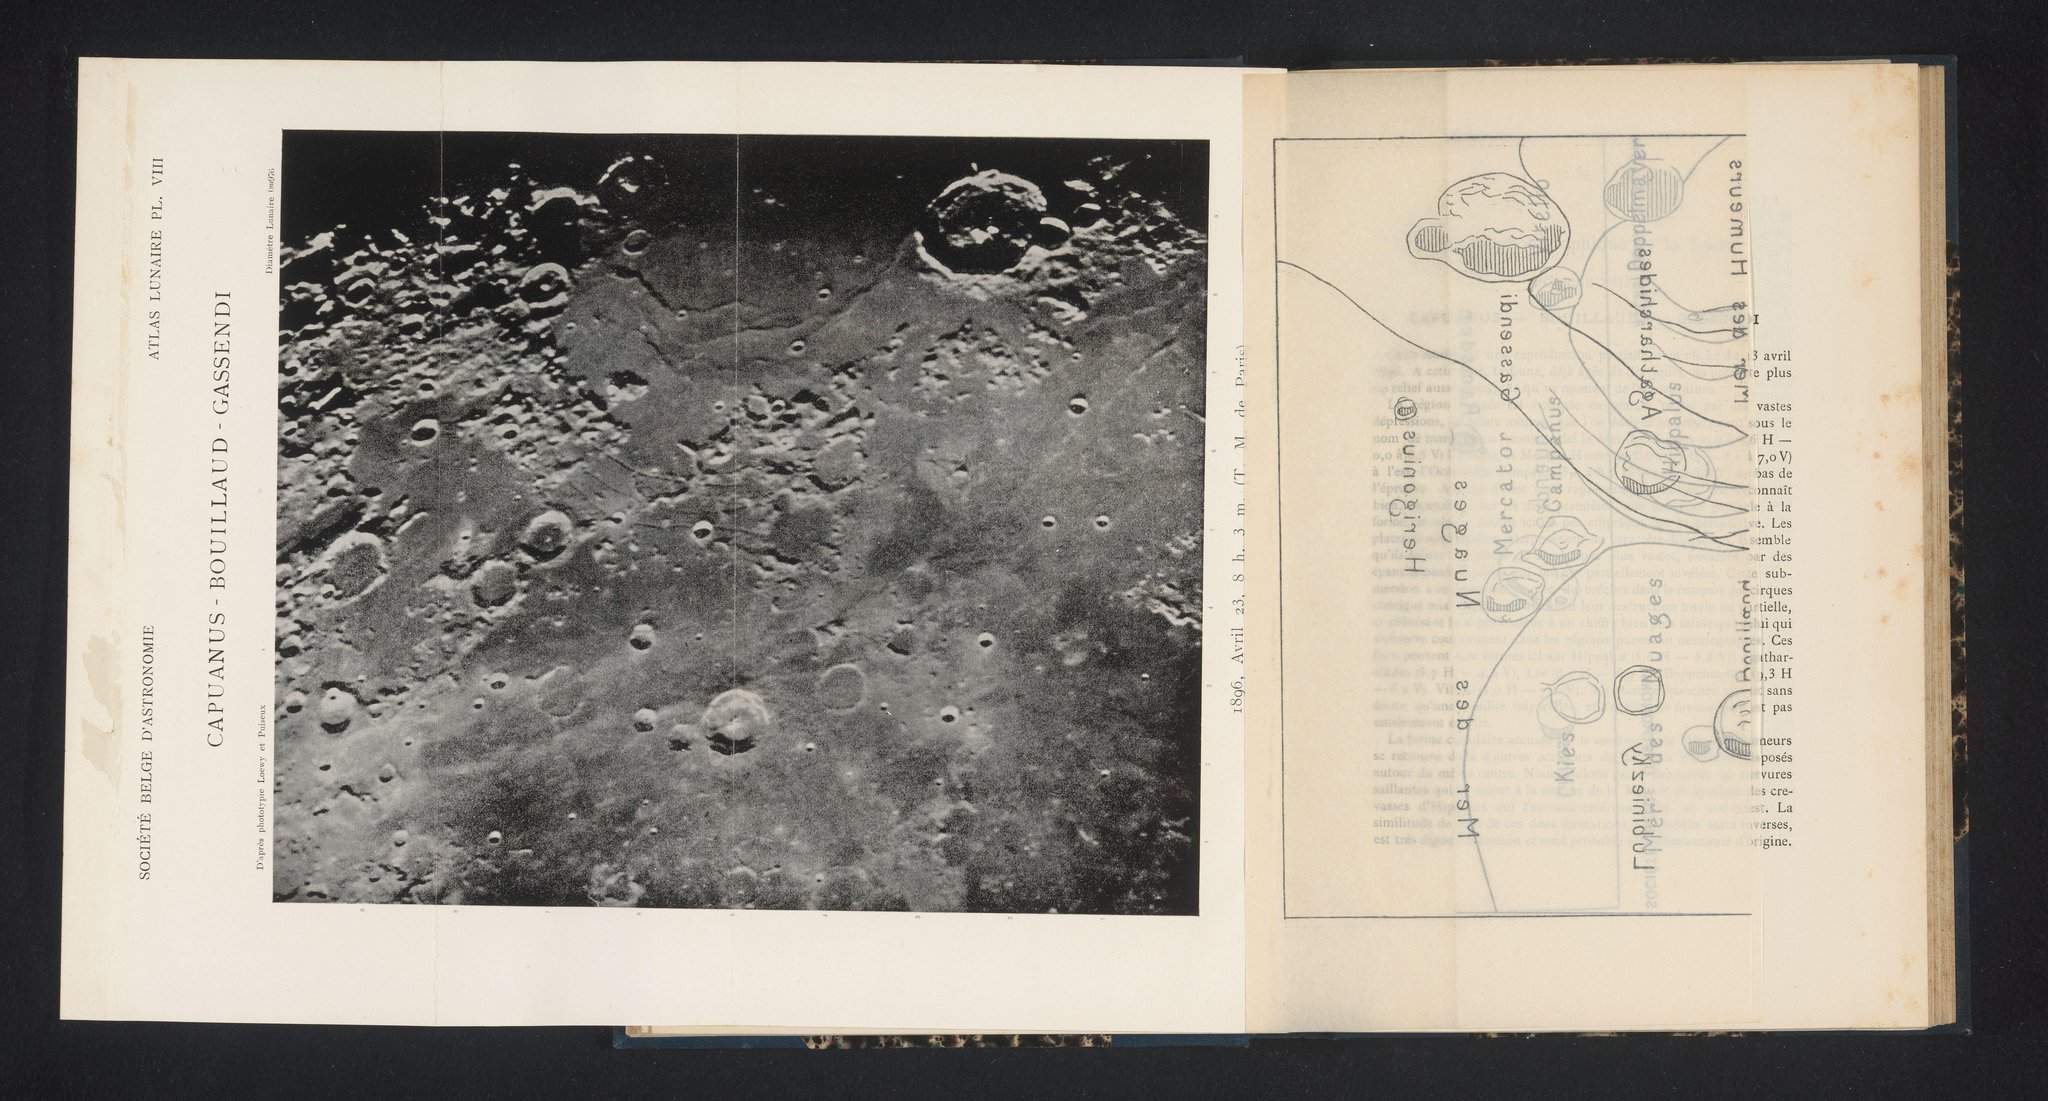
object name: page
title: Kraters op de maan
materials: paper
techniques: autotype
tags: surface of the moon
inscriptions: inscription: ‘Société Belge d'Astronomie Atlas Lunaire Pl VIII./ 1896, Avril 23, 8h. 3m. (T. M. de Paris)’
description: Transparante pagina voor prent als kaart met daarop de namen van de verschillende kraters.